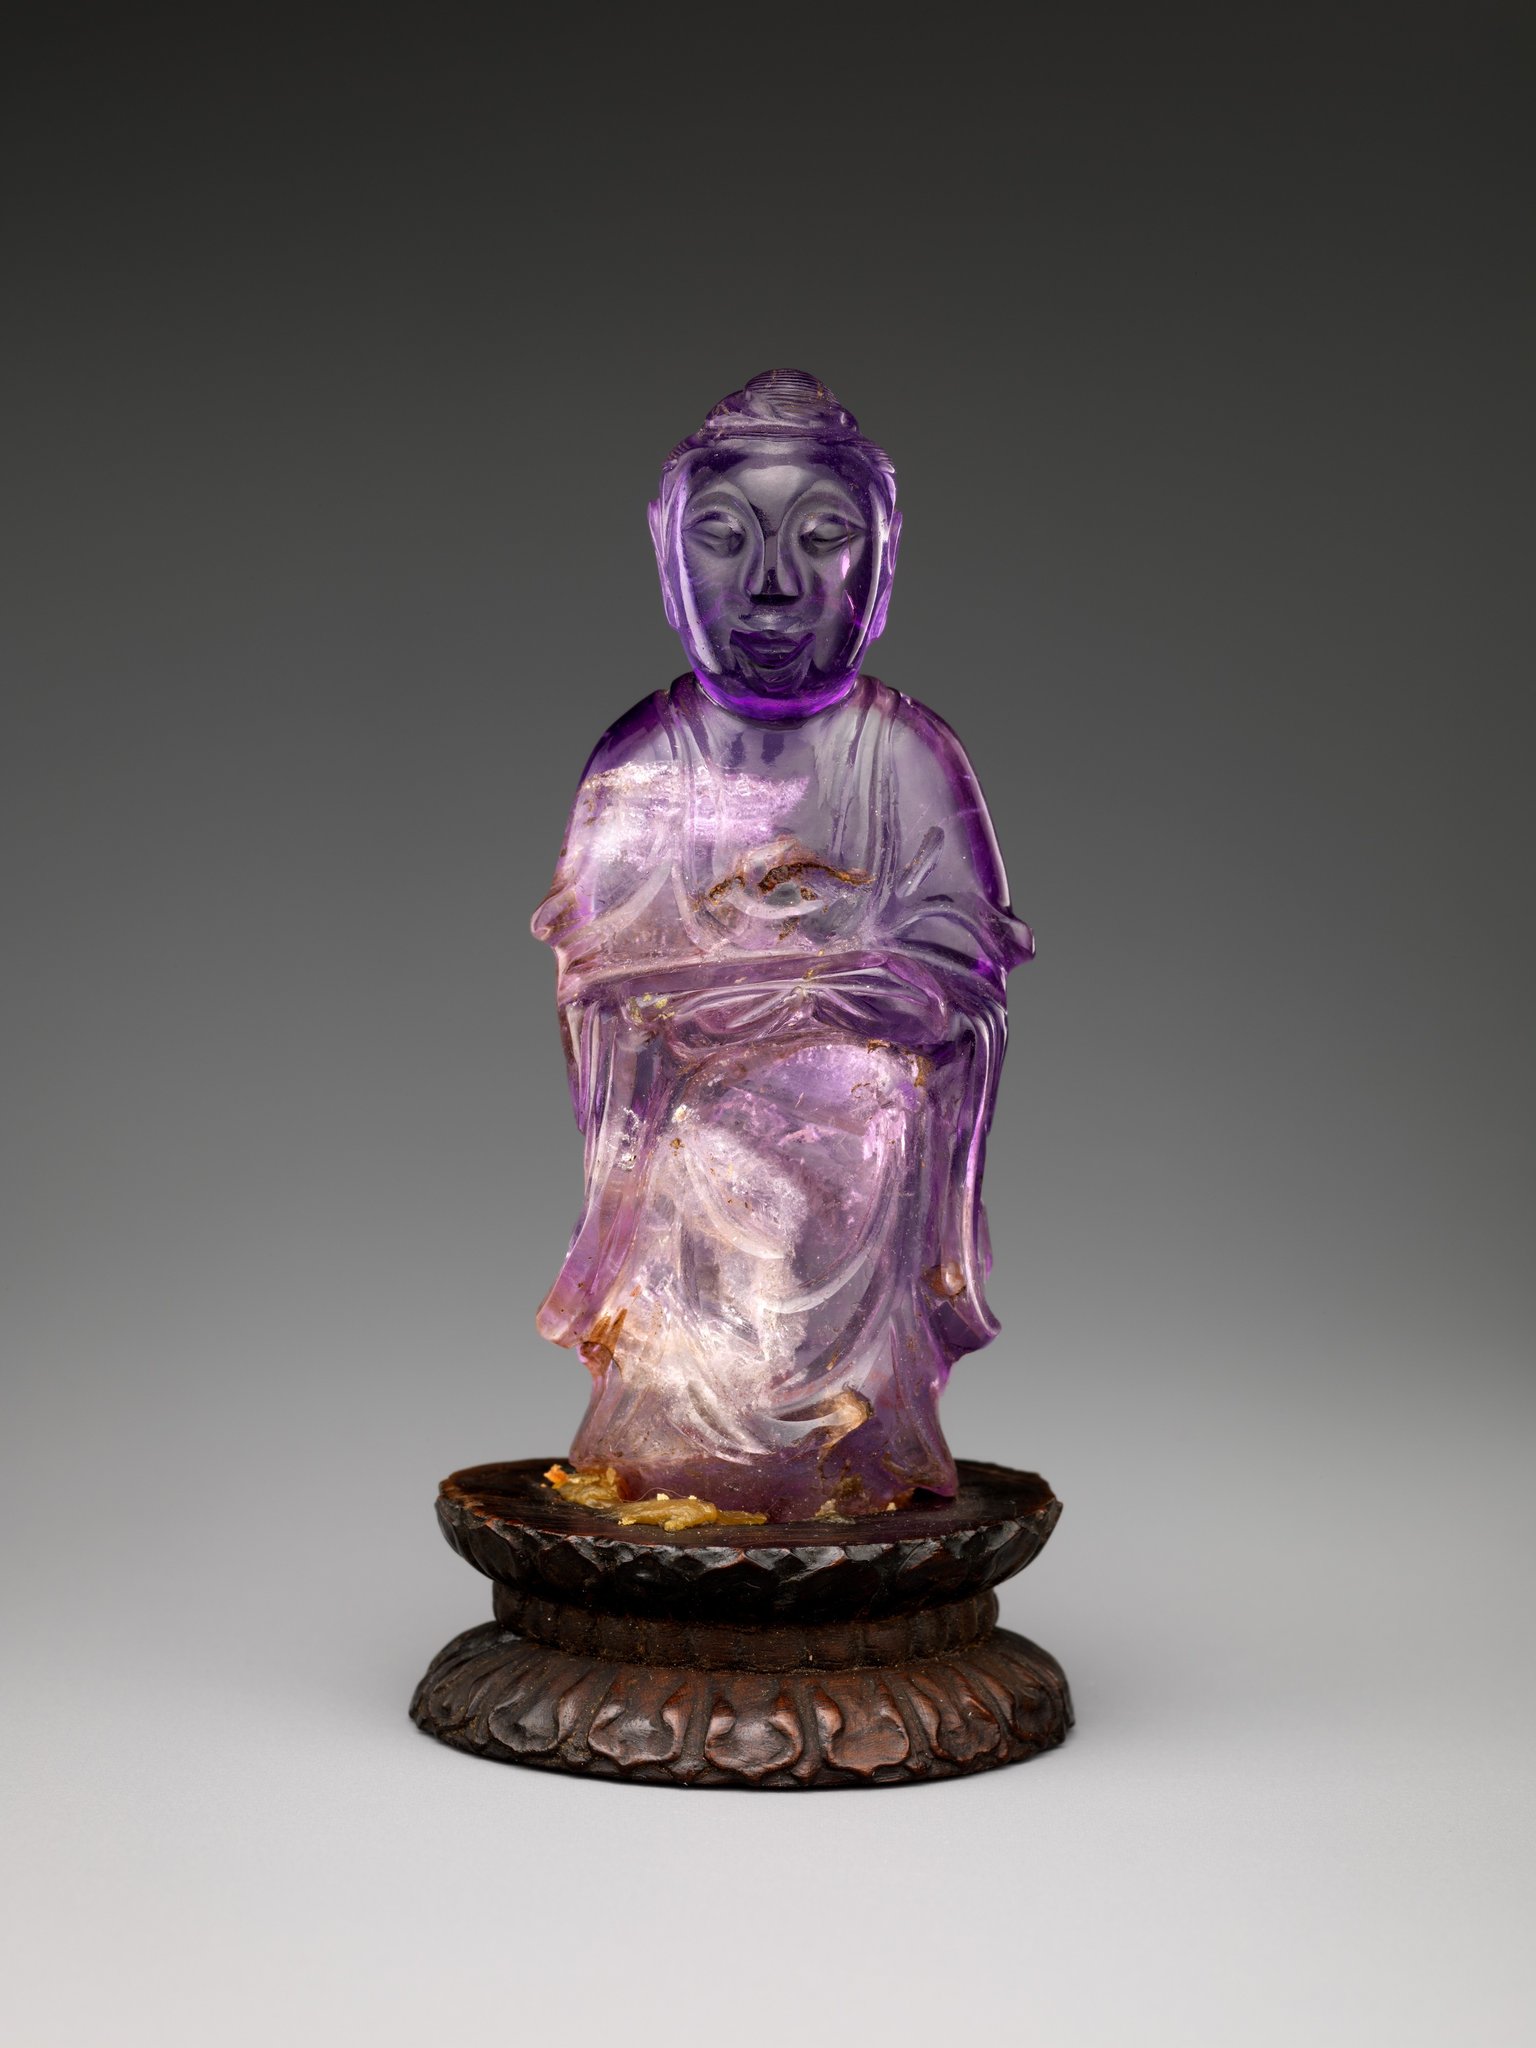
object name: figurine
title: Standing Buddha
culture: chinese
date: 1767-1833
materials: quartz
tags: buddha